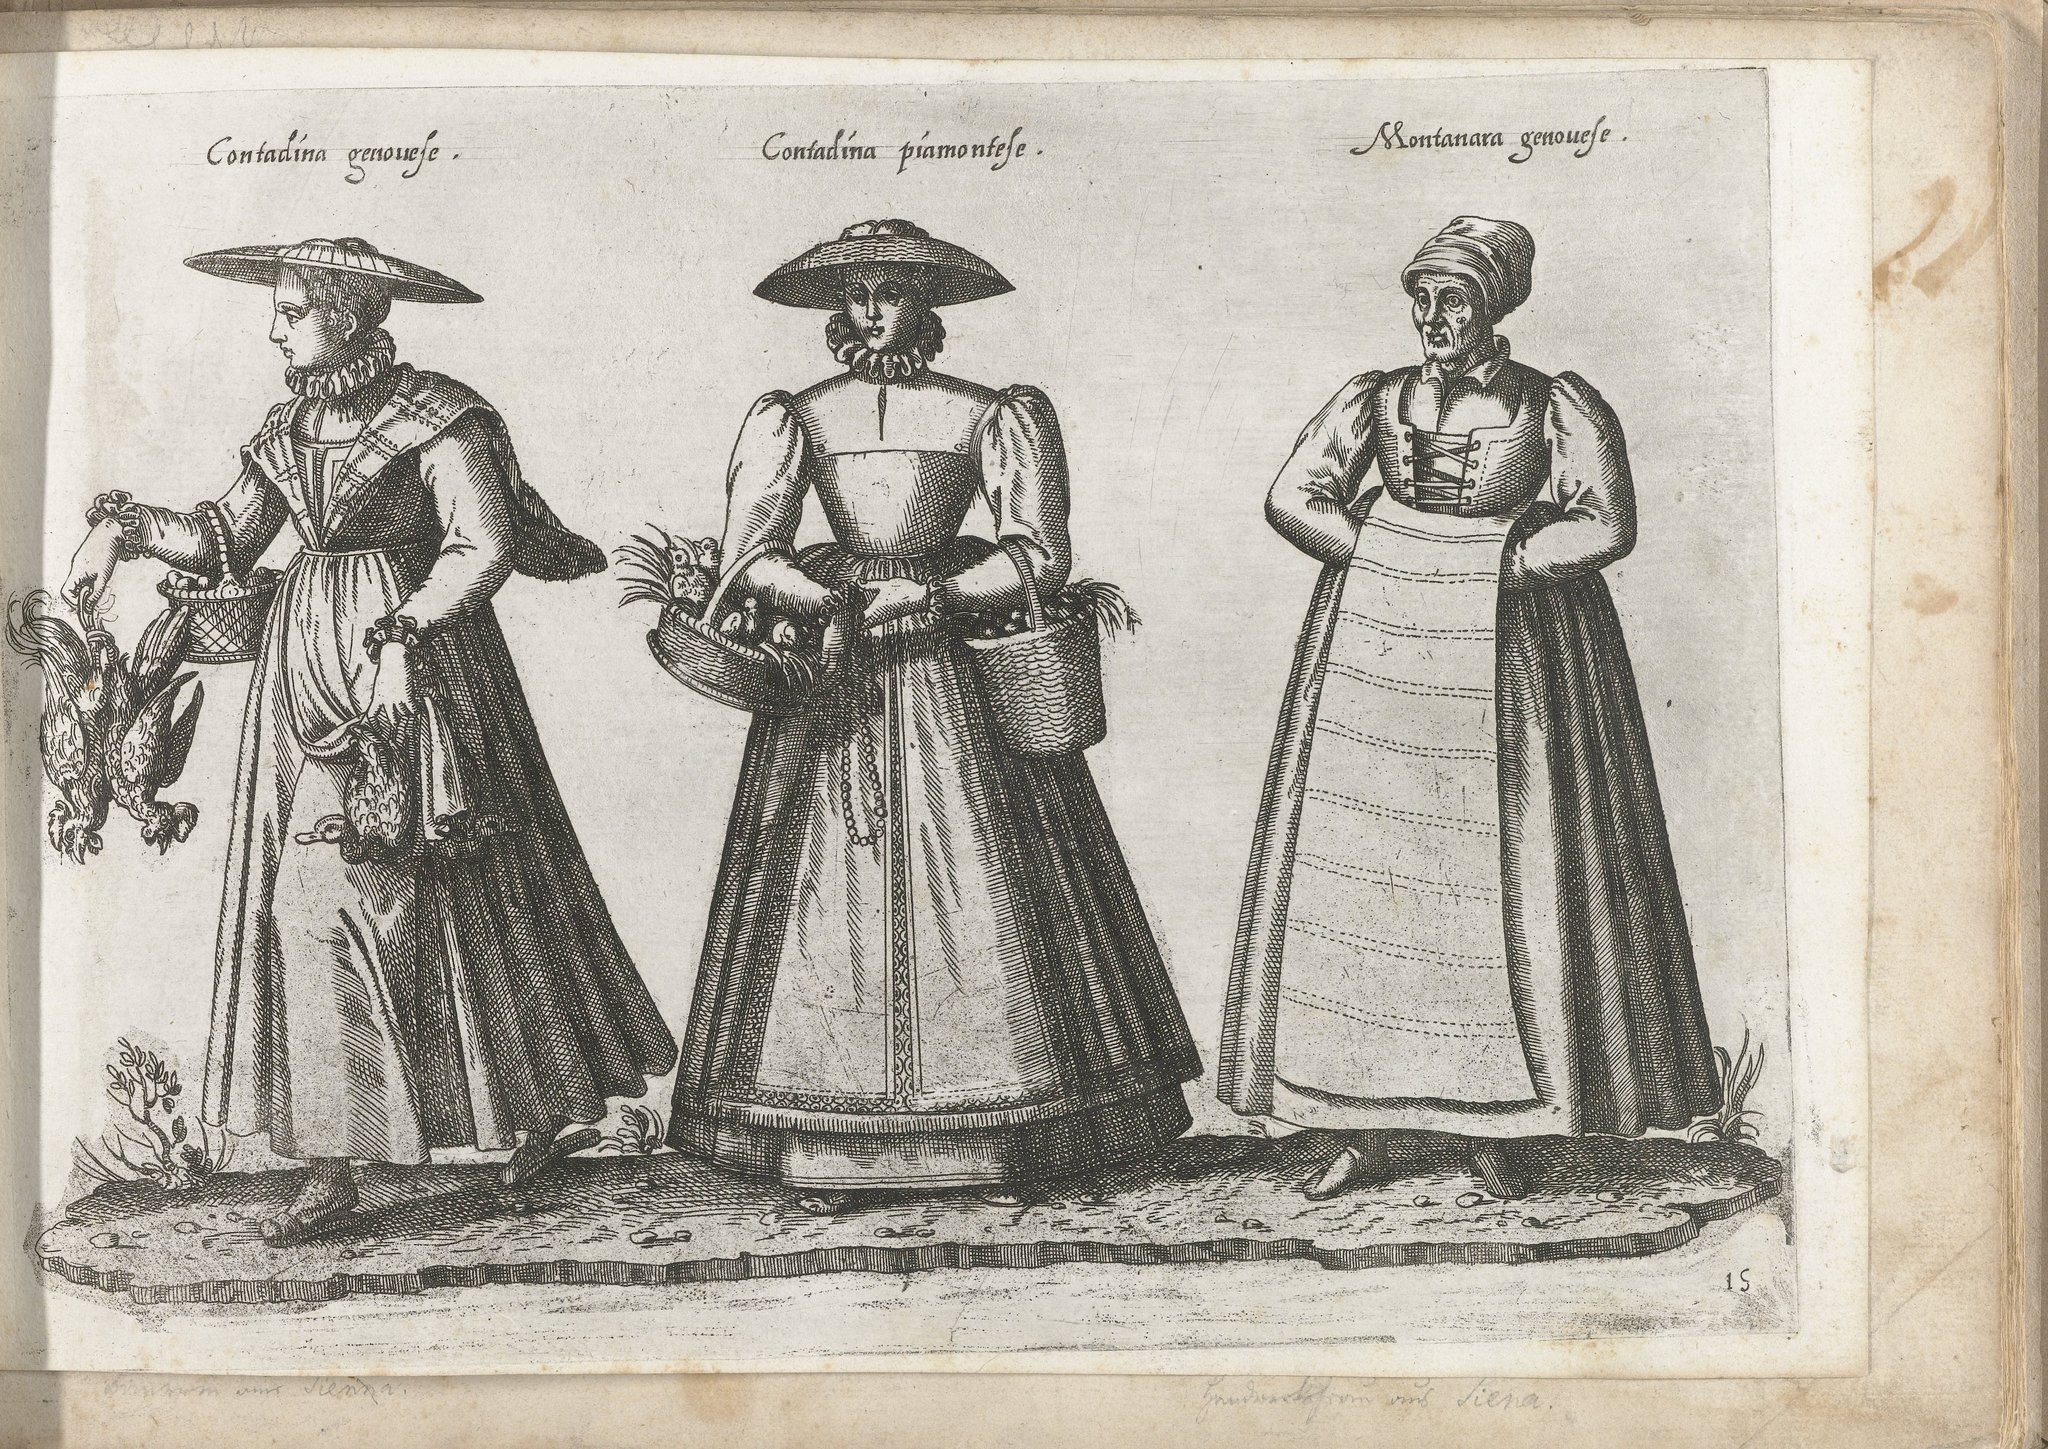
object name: costume print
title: Contadina genovese / Contadina piamontese / Mantanara genovese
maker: bartolomeo grassi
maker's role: publisher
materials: paper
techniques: engraving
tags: dairy products and eggs, container made of plant material other than wood: basket, fowl (cock, hen, chicken, etc.), europeans (with name) (+ costume)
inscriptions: number: ‘14’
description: Links een boerenvrouw met platte hoed op, lopend naar links, een mand met eieren aan de arm, kippen en en eend in de hand. In het midden een boerenvrouw uit iemonte, van voren gezien, aan de rechterarm een mand met kuikens, links een mand met fruit. Op het hoofd een platte hoed. Rechts een oude vrouw met de handen onder haar schort. Prent nr. 15 uit album 'Dei veri ritratti degl'habiti di tvtte le parti del mondo intagliati in rame per opra di Bartolomeo Grassi', 1585.